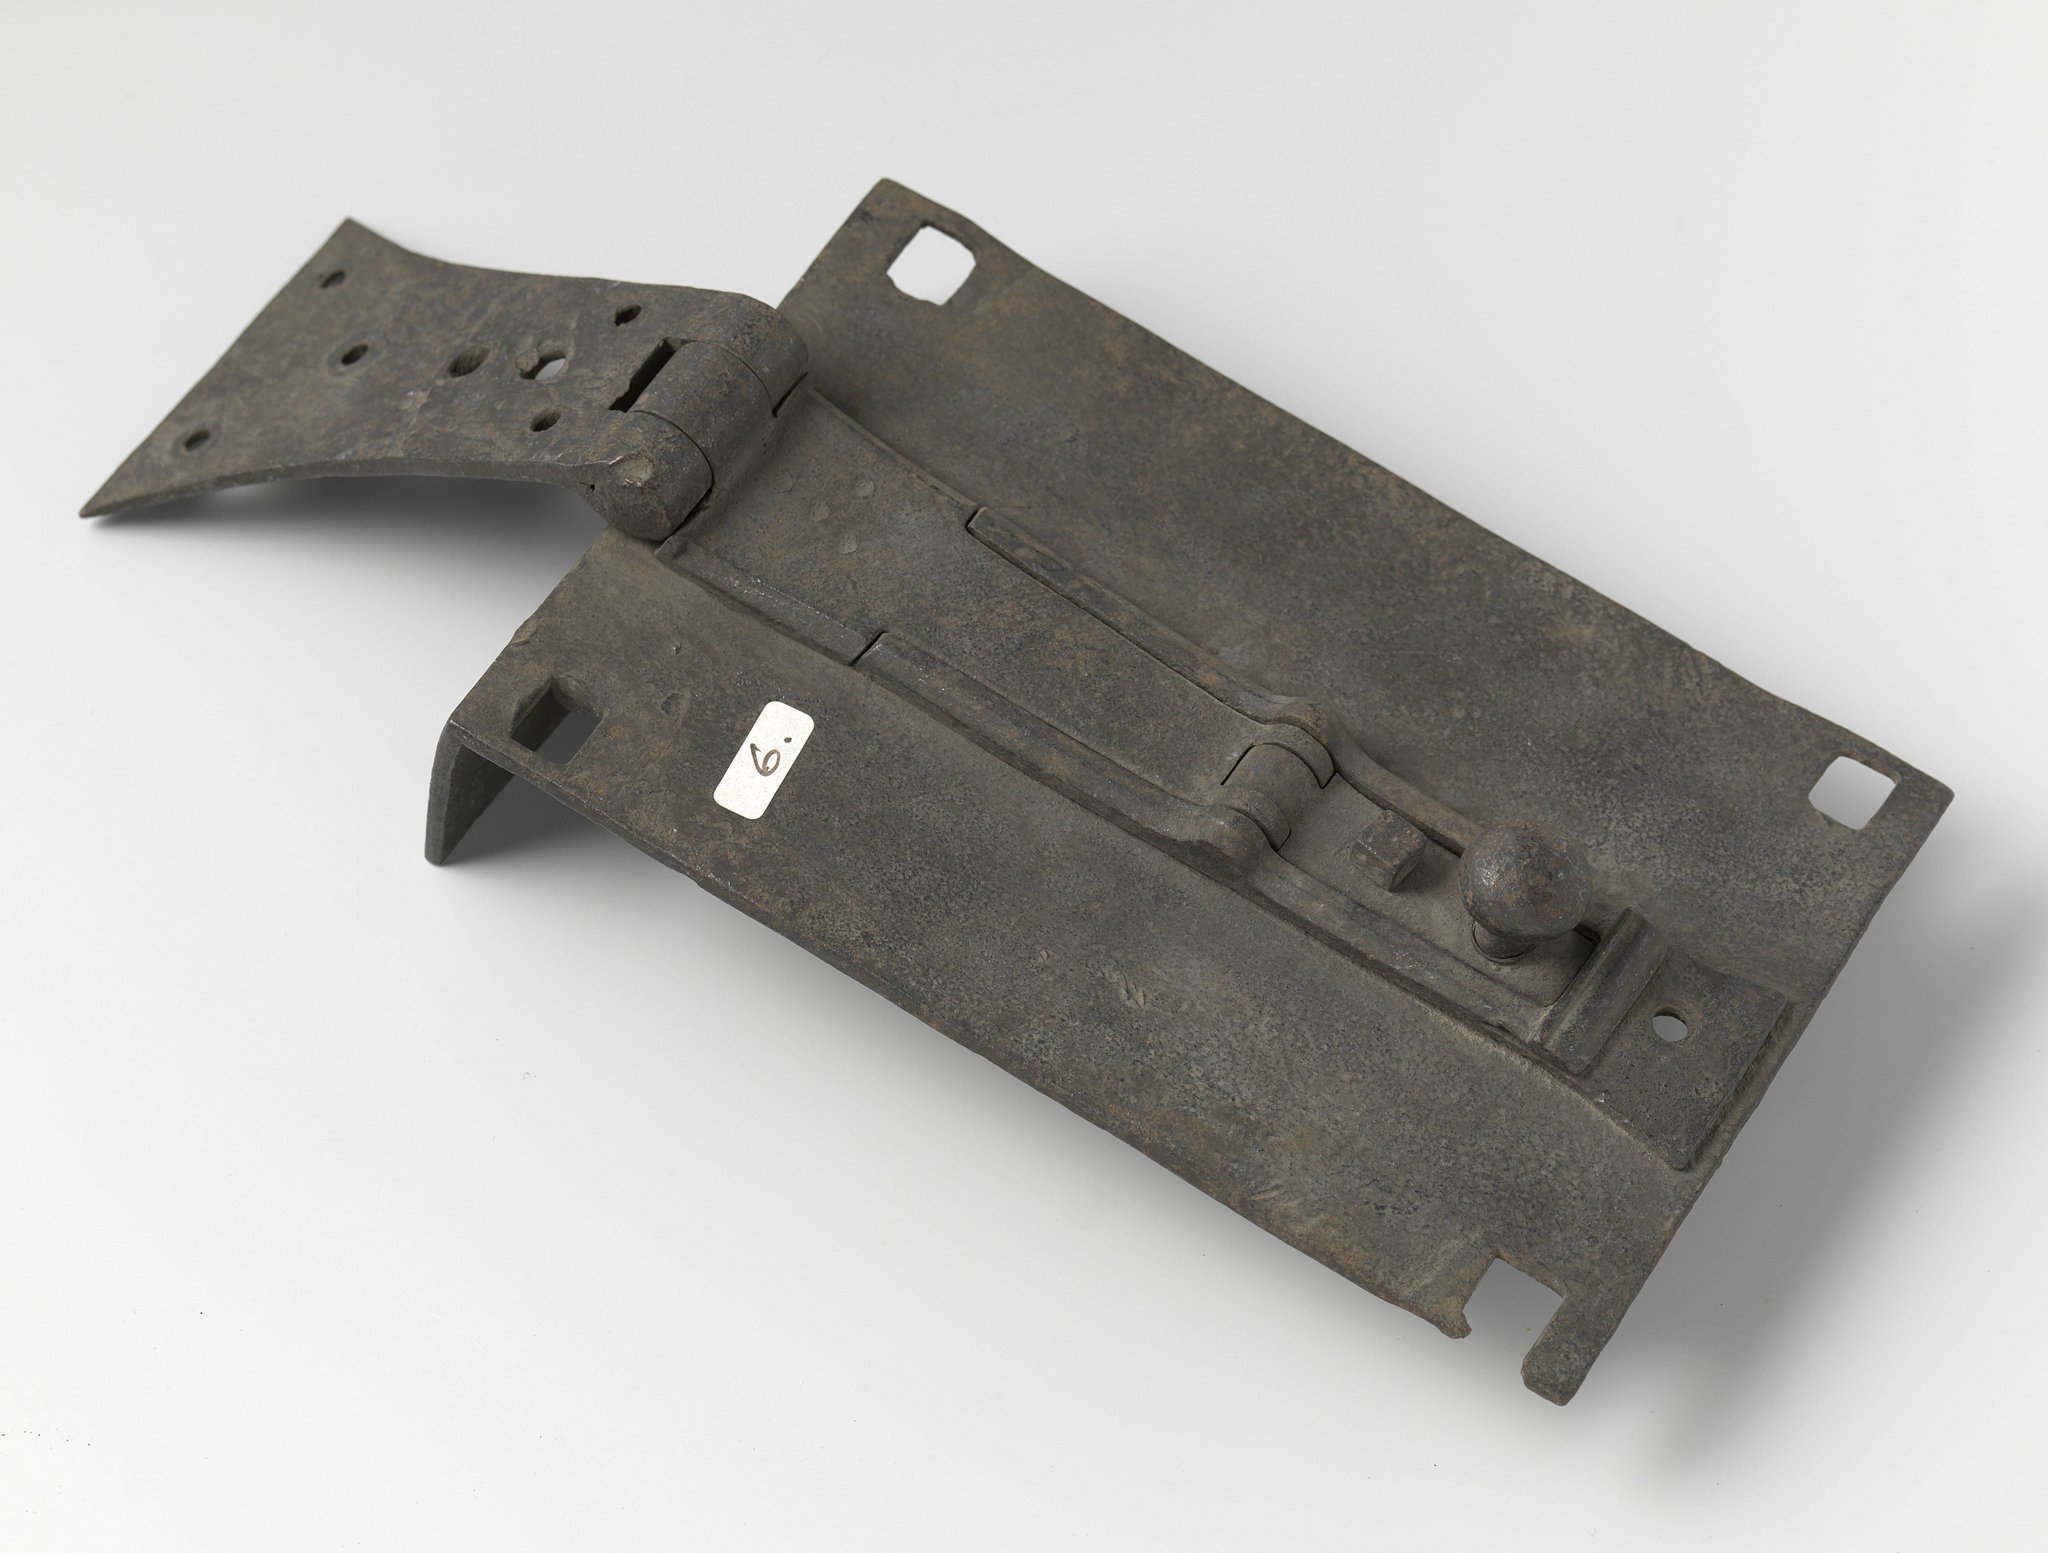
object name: slotplaat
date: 1000-2000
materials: metal